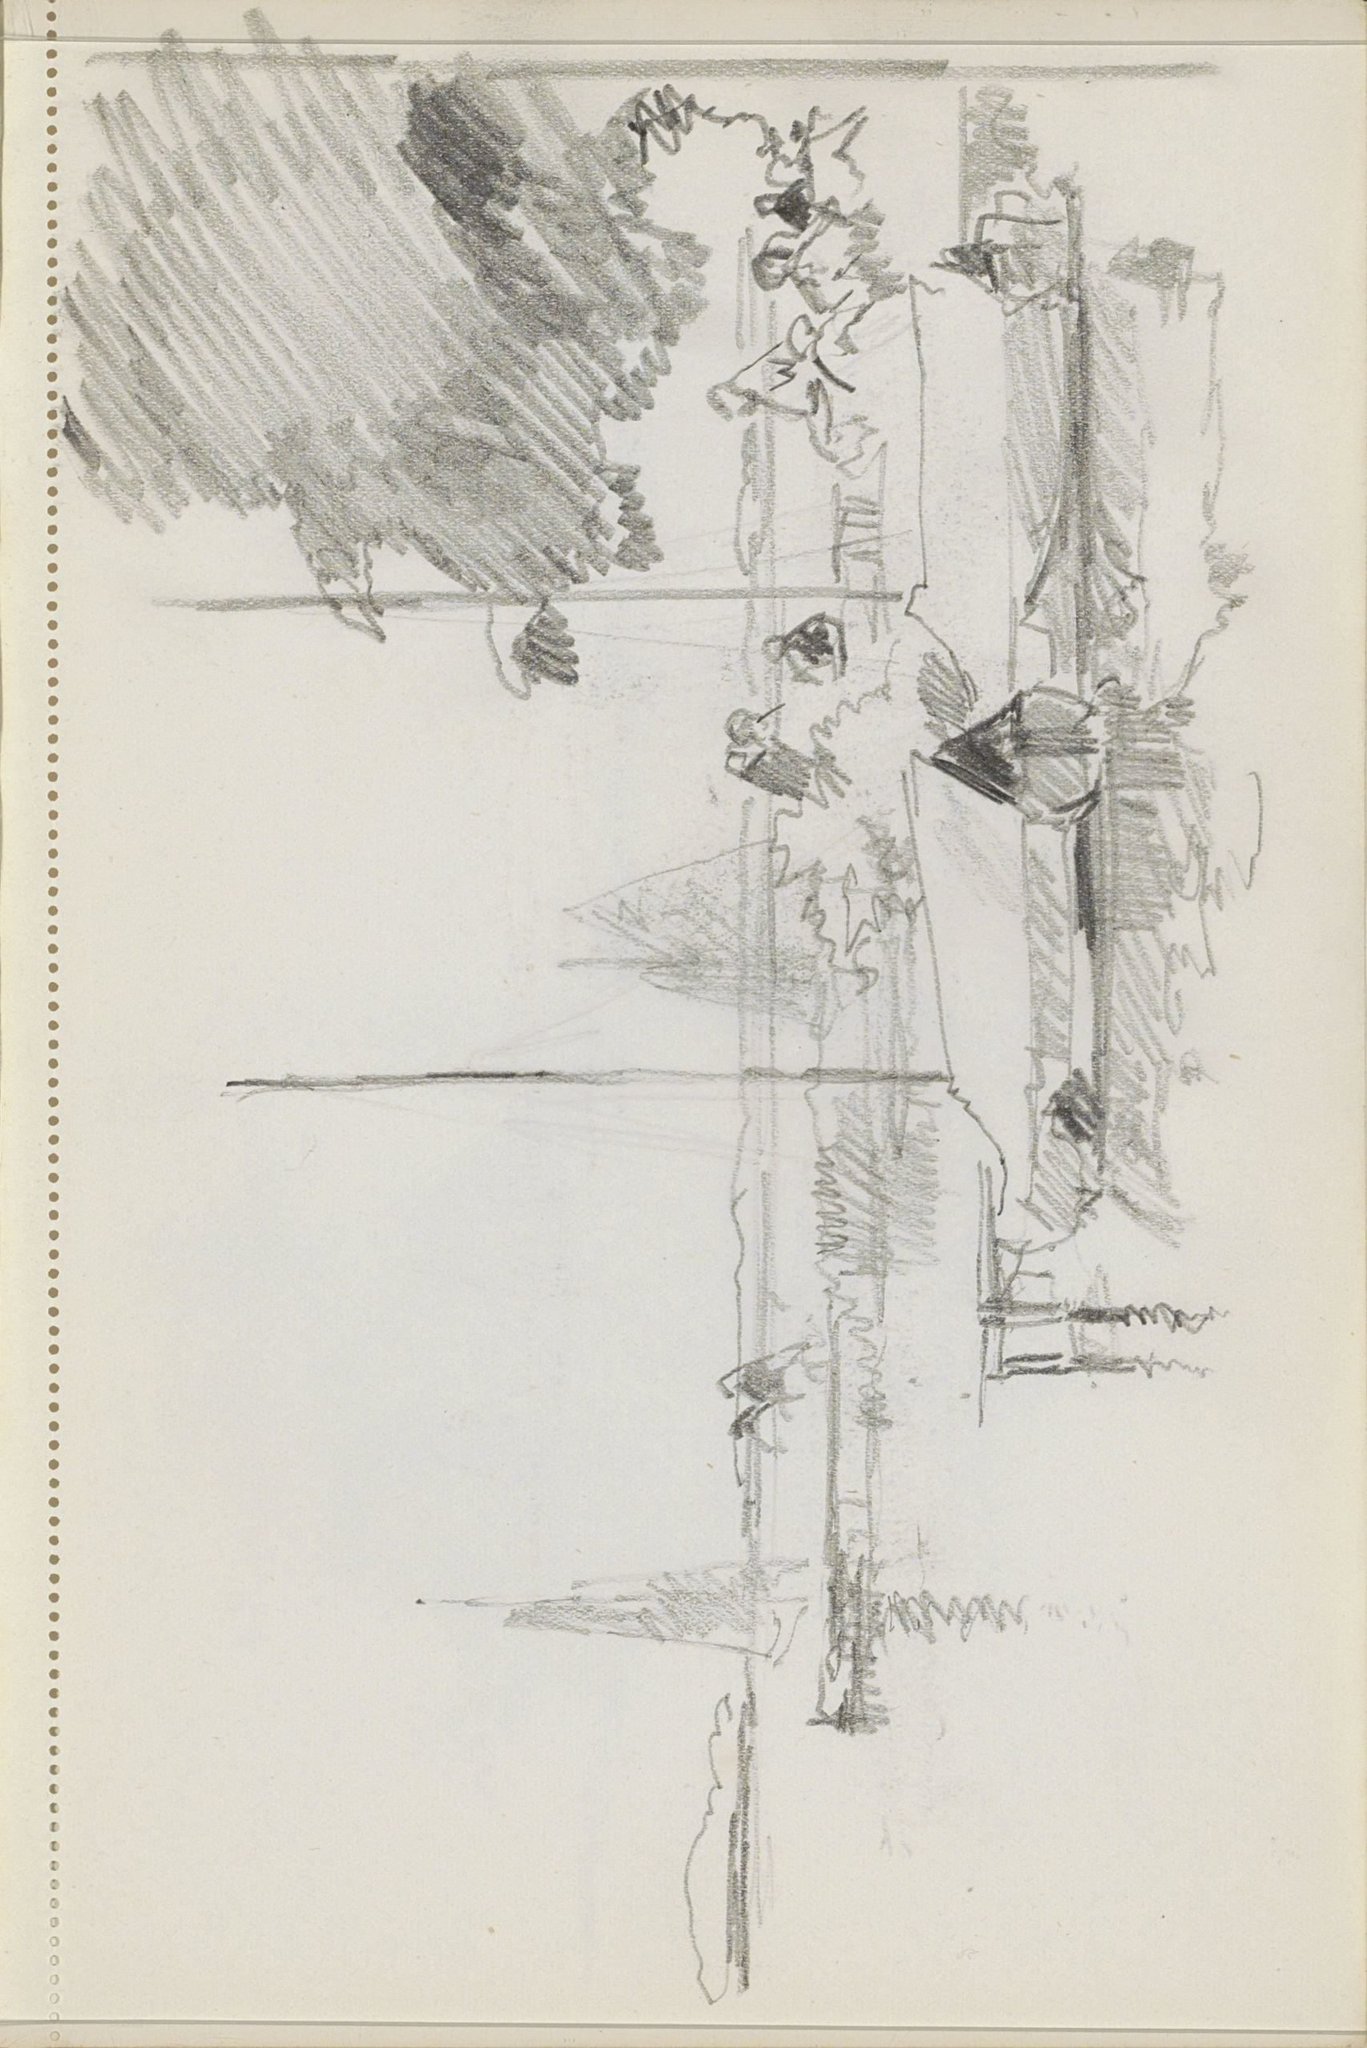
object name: sketchbook leaf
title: Aangemeerde zeilboten aan een waterkant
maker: cornelis vreedenburgh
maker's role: draughtsman, print maker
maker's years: 1880-1946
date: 1890-1946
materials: paper, pencil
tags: sailing-ship, sailing-boat, landscapes with waters, waterscapes, seascapes (in the temperate zone)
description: Aan de waterkant zitten figuren onder een boom. Blad 35 recto uit een schetsboek met uit 75 bladen.